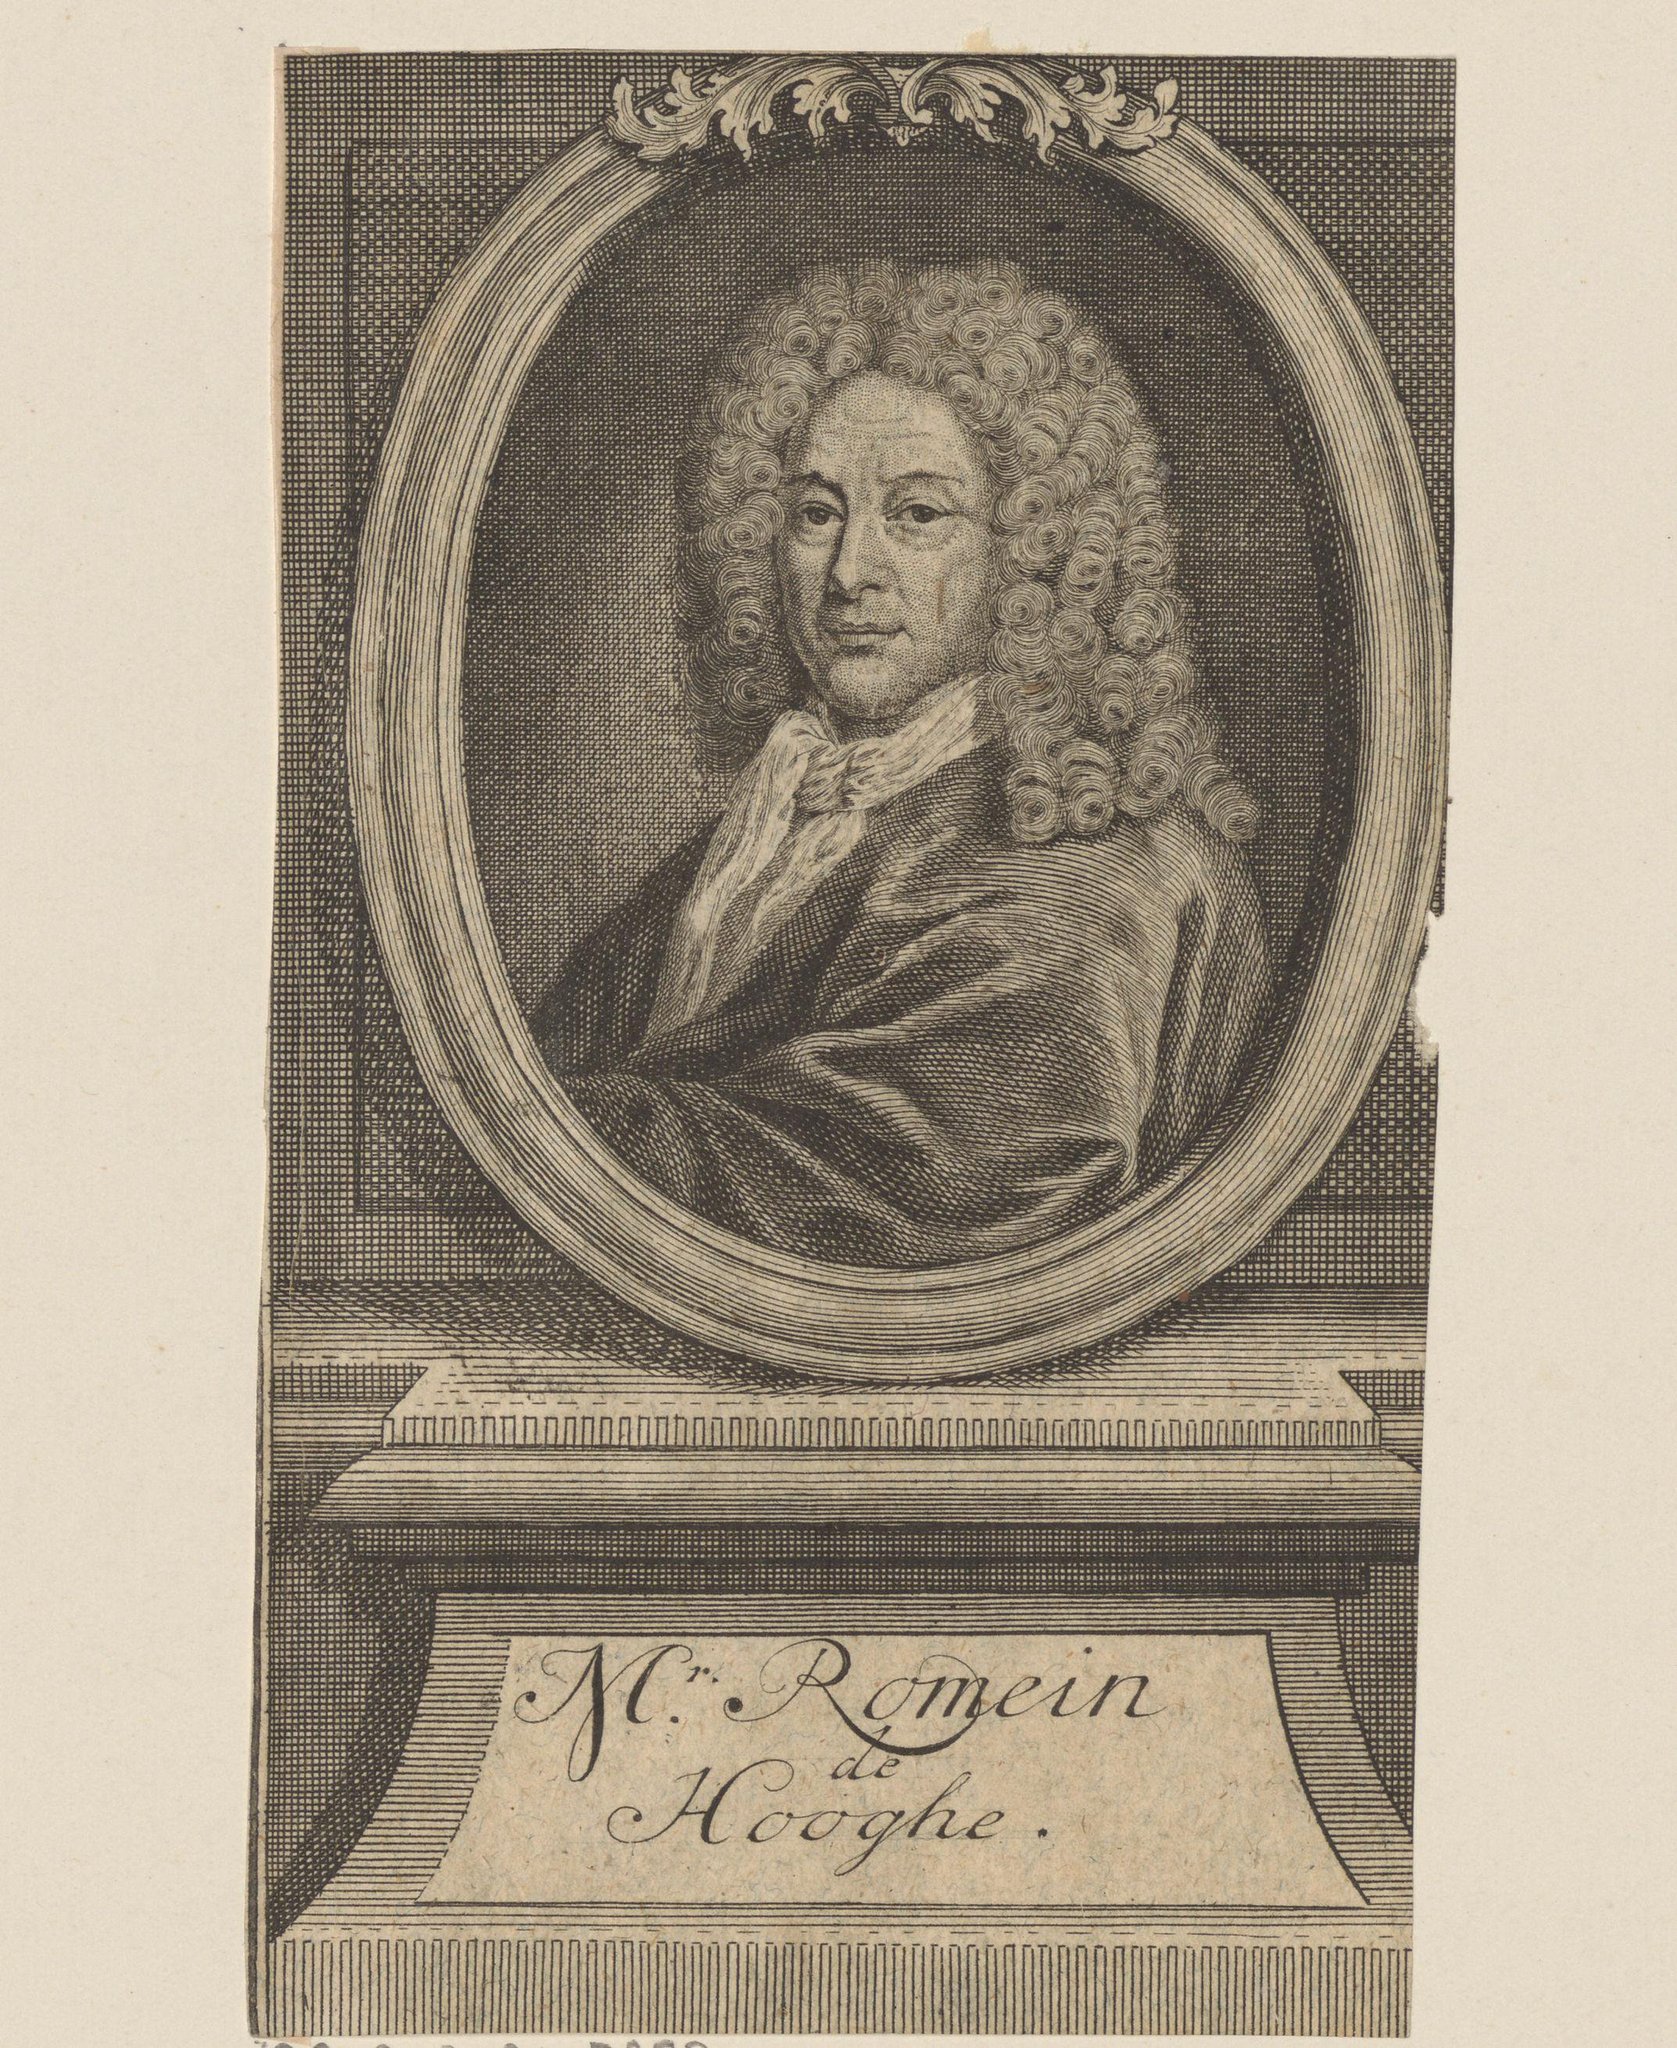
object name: print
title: Portret van Romeyn de Hooghe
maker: johann christoph sysang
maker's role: print maker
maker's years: 1703-1757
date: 1713-1757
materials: paper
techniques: engraving, etching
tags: amsterdam, haarlem, painter, print maker, draughtsman, goldsmith, romeyn de hooghe, historical persons, portrait, self-portrait of graphic artist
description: Prent gebruikt in: Zuverläßige Nachrichten von dem gegenwärtigen Zustande Veränderung und Wachsthum der Wissenschaften. Leipzig: Johann Friedrich Gleditsch, 1749, dl. 117.